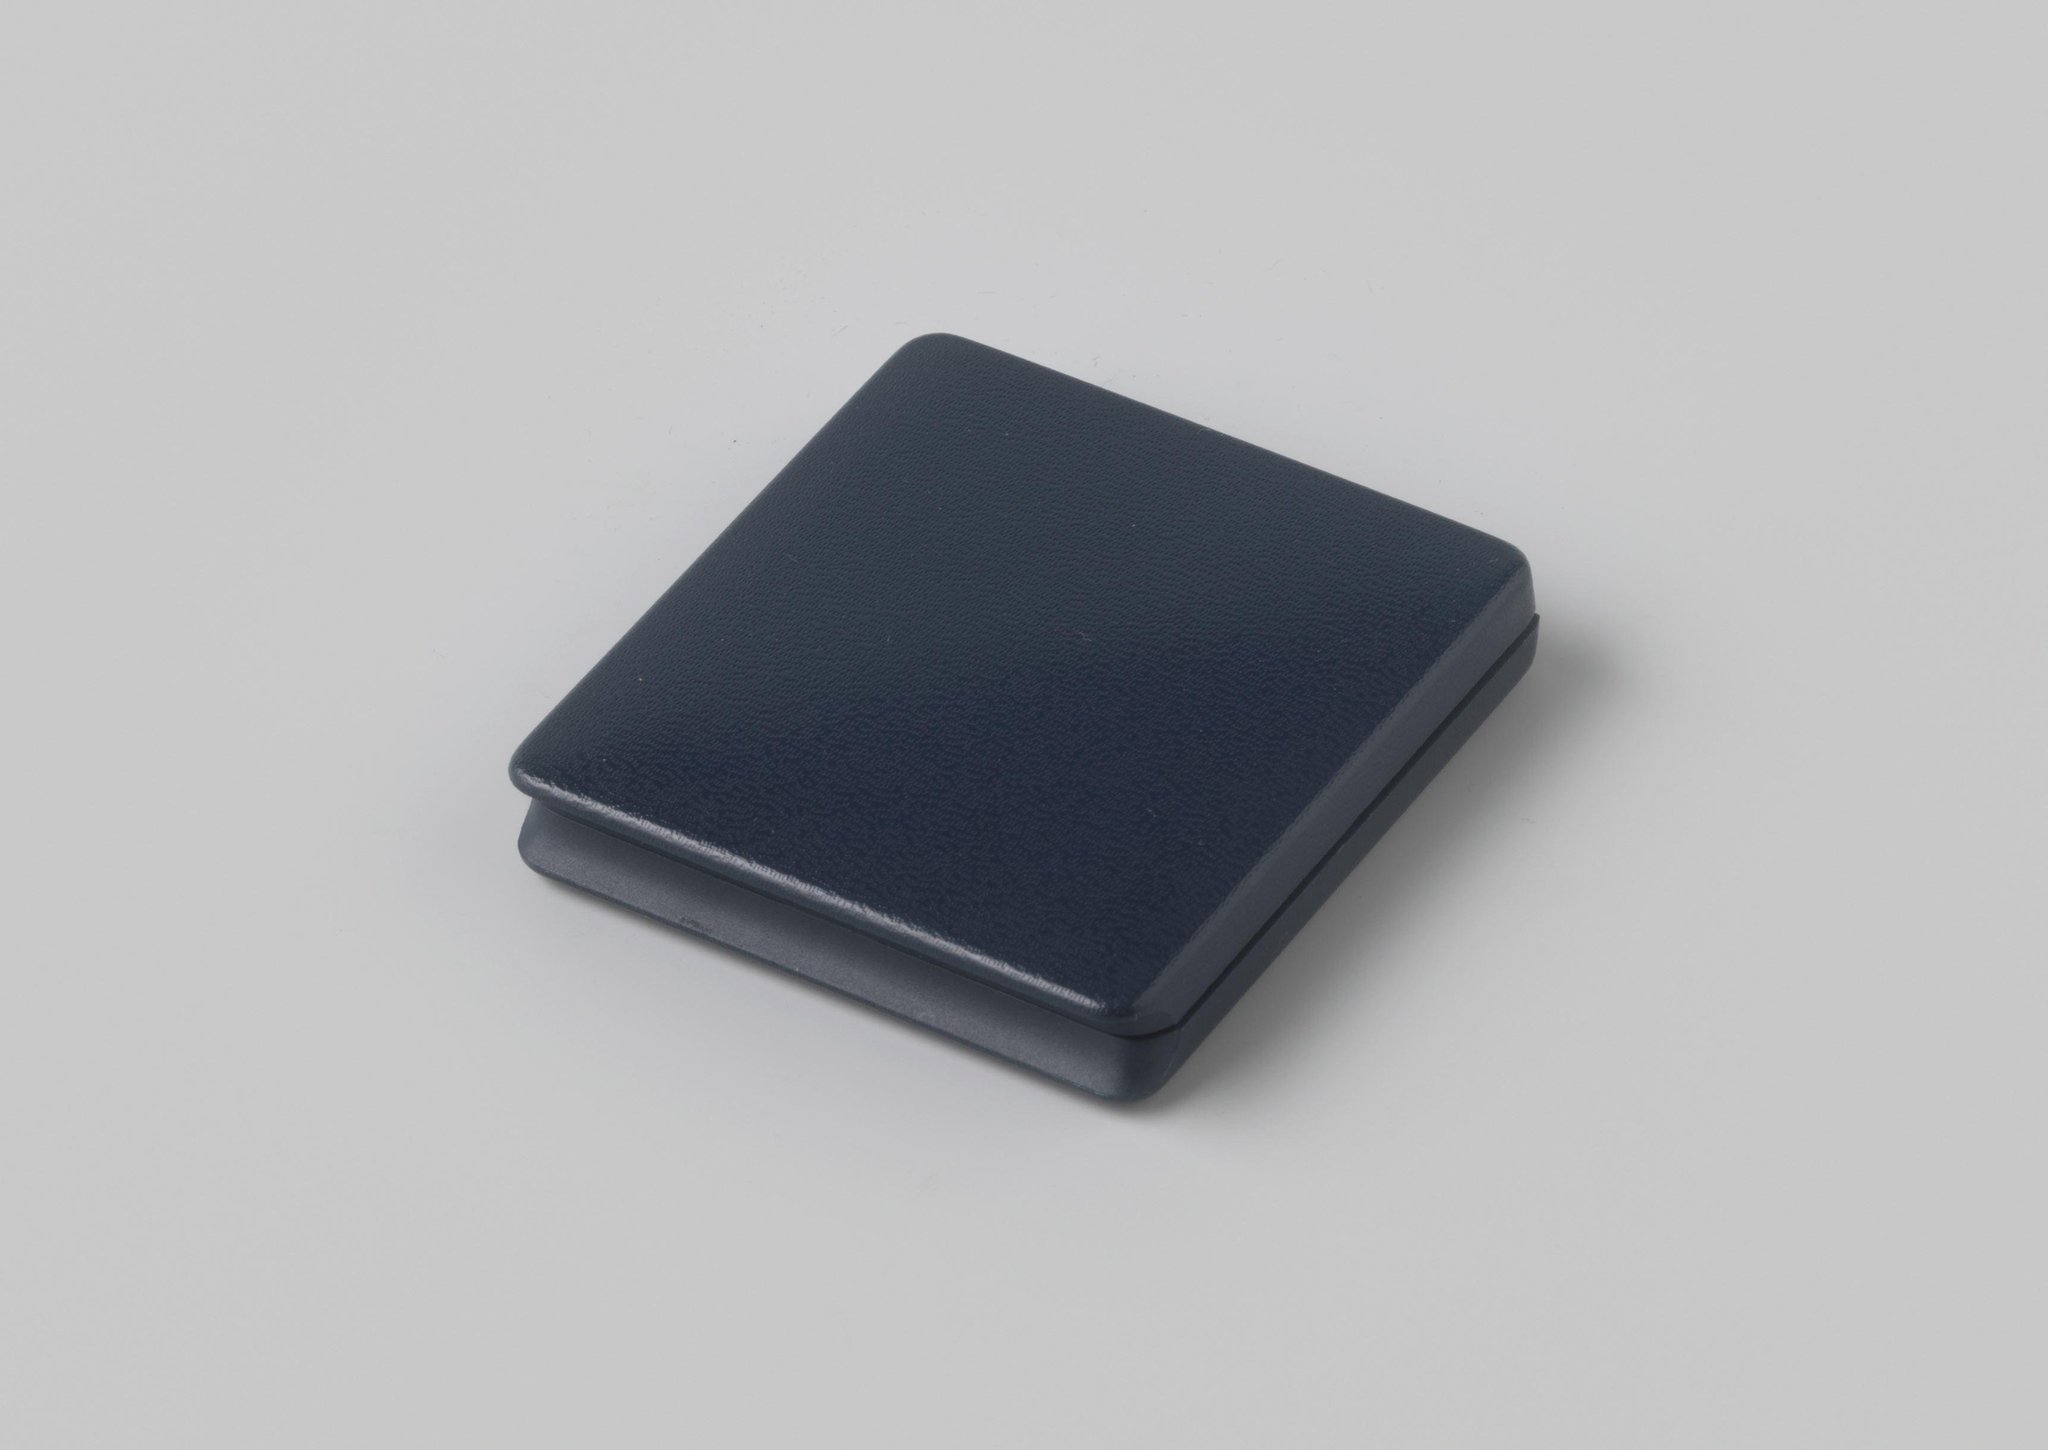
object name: box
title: Doos behorend bij een dukaat van goud afkomstig van het wrak van de Oost-Indiëvaarder 't Vliegend Hart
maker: Anonymous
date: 1729-1734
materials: felt, plastic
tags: 't vliegend hart (schip)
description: Blauw doosje van kusntstof behorend bij een ducaton afkomstig van het wrak van de Oost-Indiëvaarder 't Vliegend Hart. De binnenkant is bekleedt met blauw vilt. Aan de binnenzijde van de deksel staat 'Het vliegend Hart, treasure recovered from the Dutch East Indiaman 't Vliegend Hart (1735).